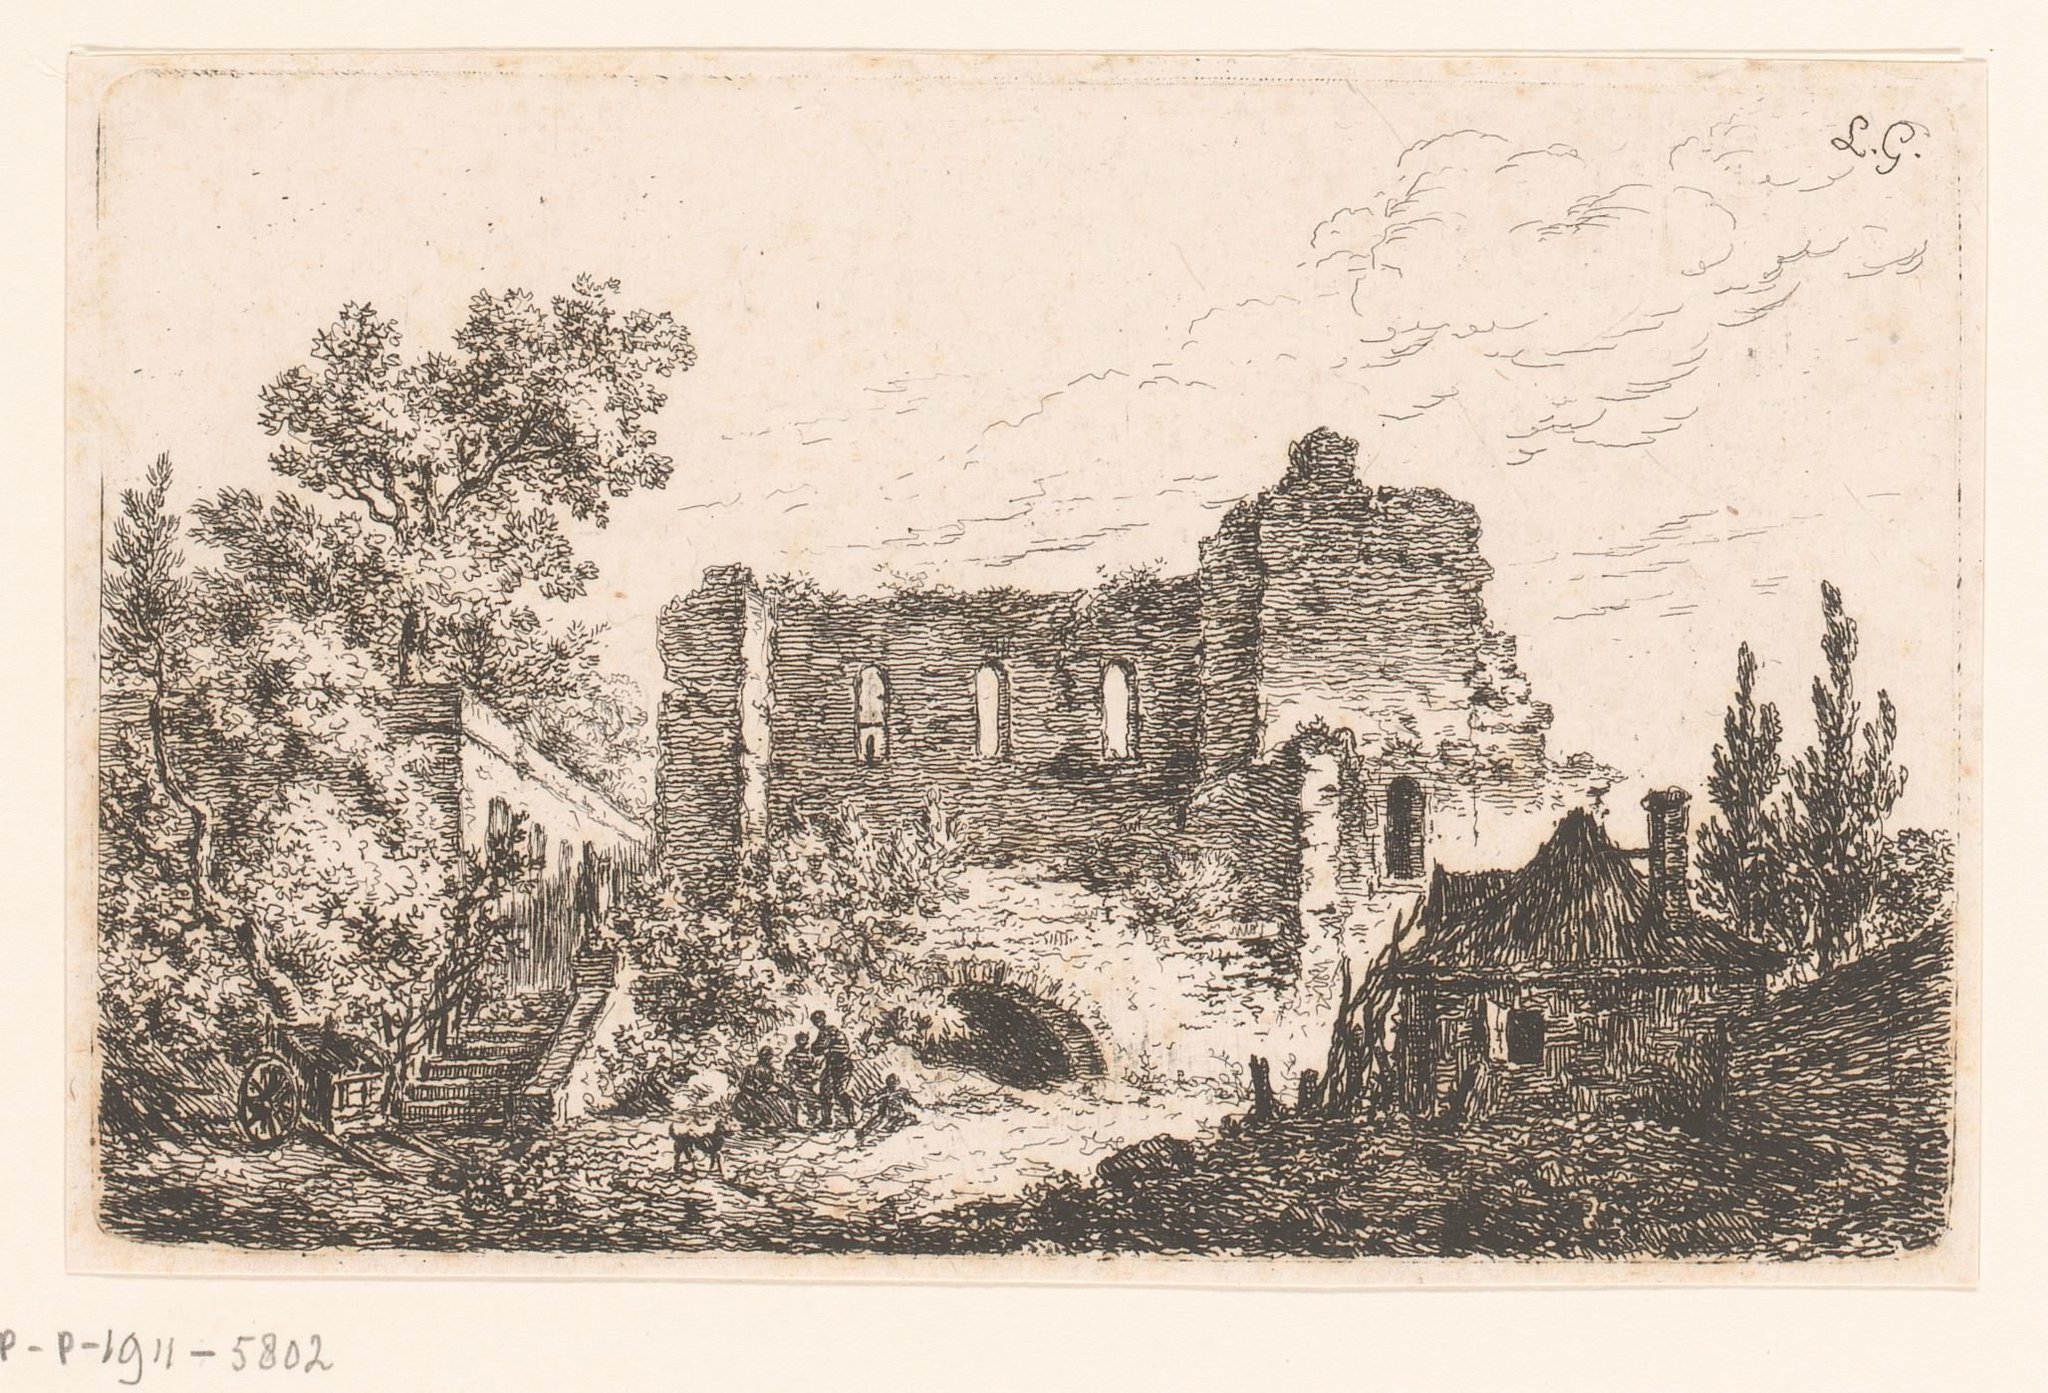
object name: print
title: Landschap met een huis naast een ruïne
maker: sauveur legros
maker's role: print maker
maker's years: 1754-1834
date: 1764-1834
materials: paper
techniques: etching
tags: landscape with ruins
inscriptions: collector's mark: Lugt 2228